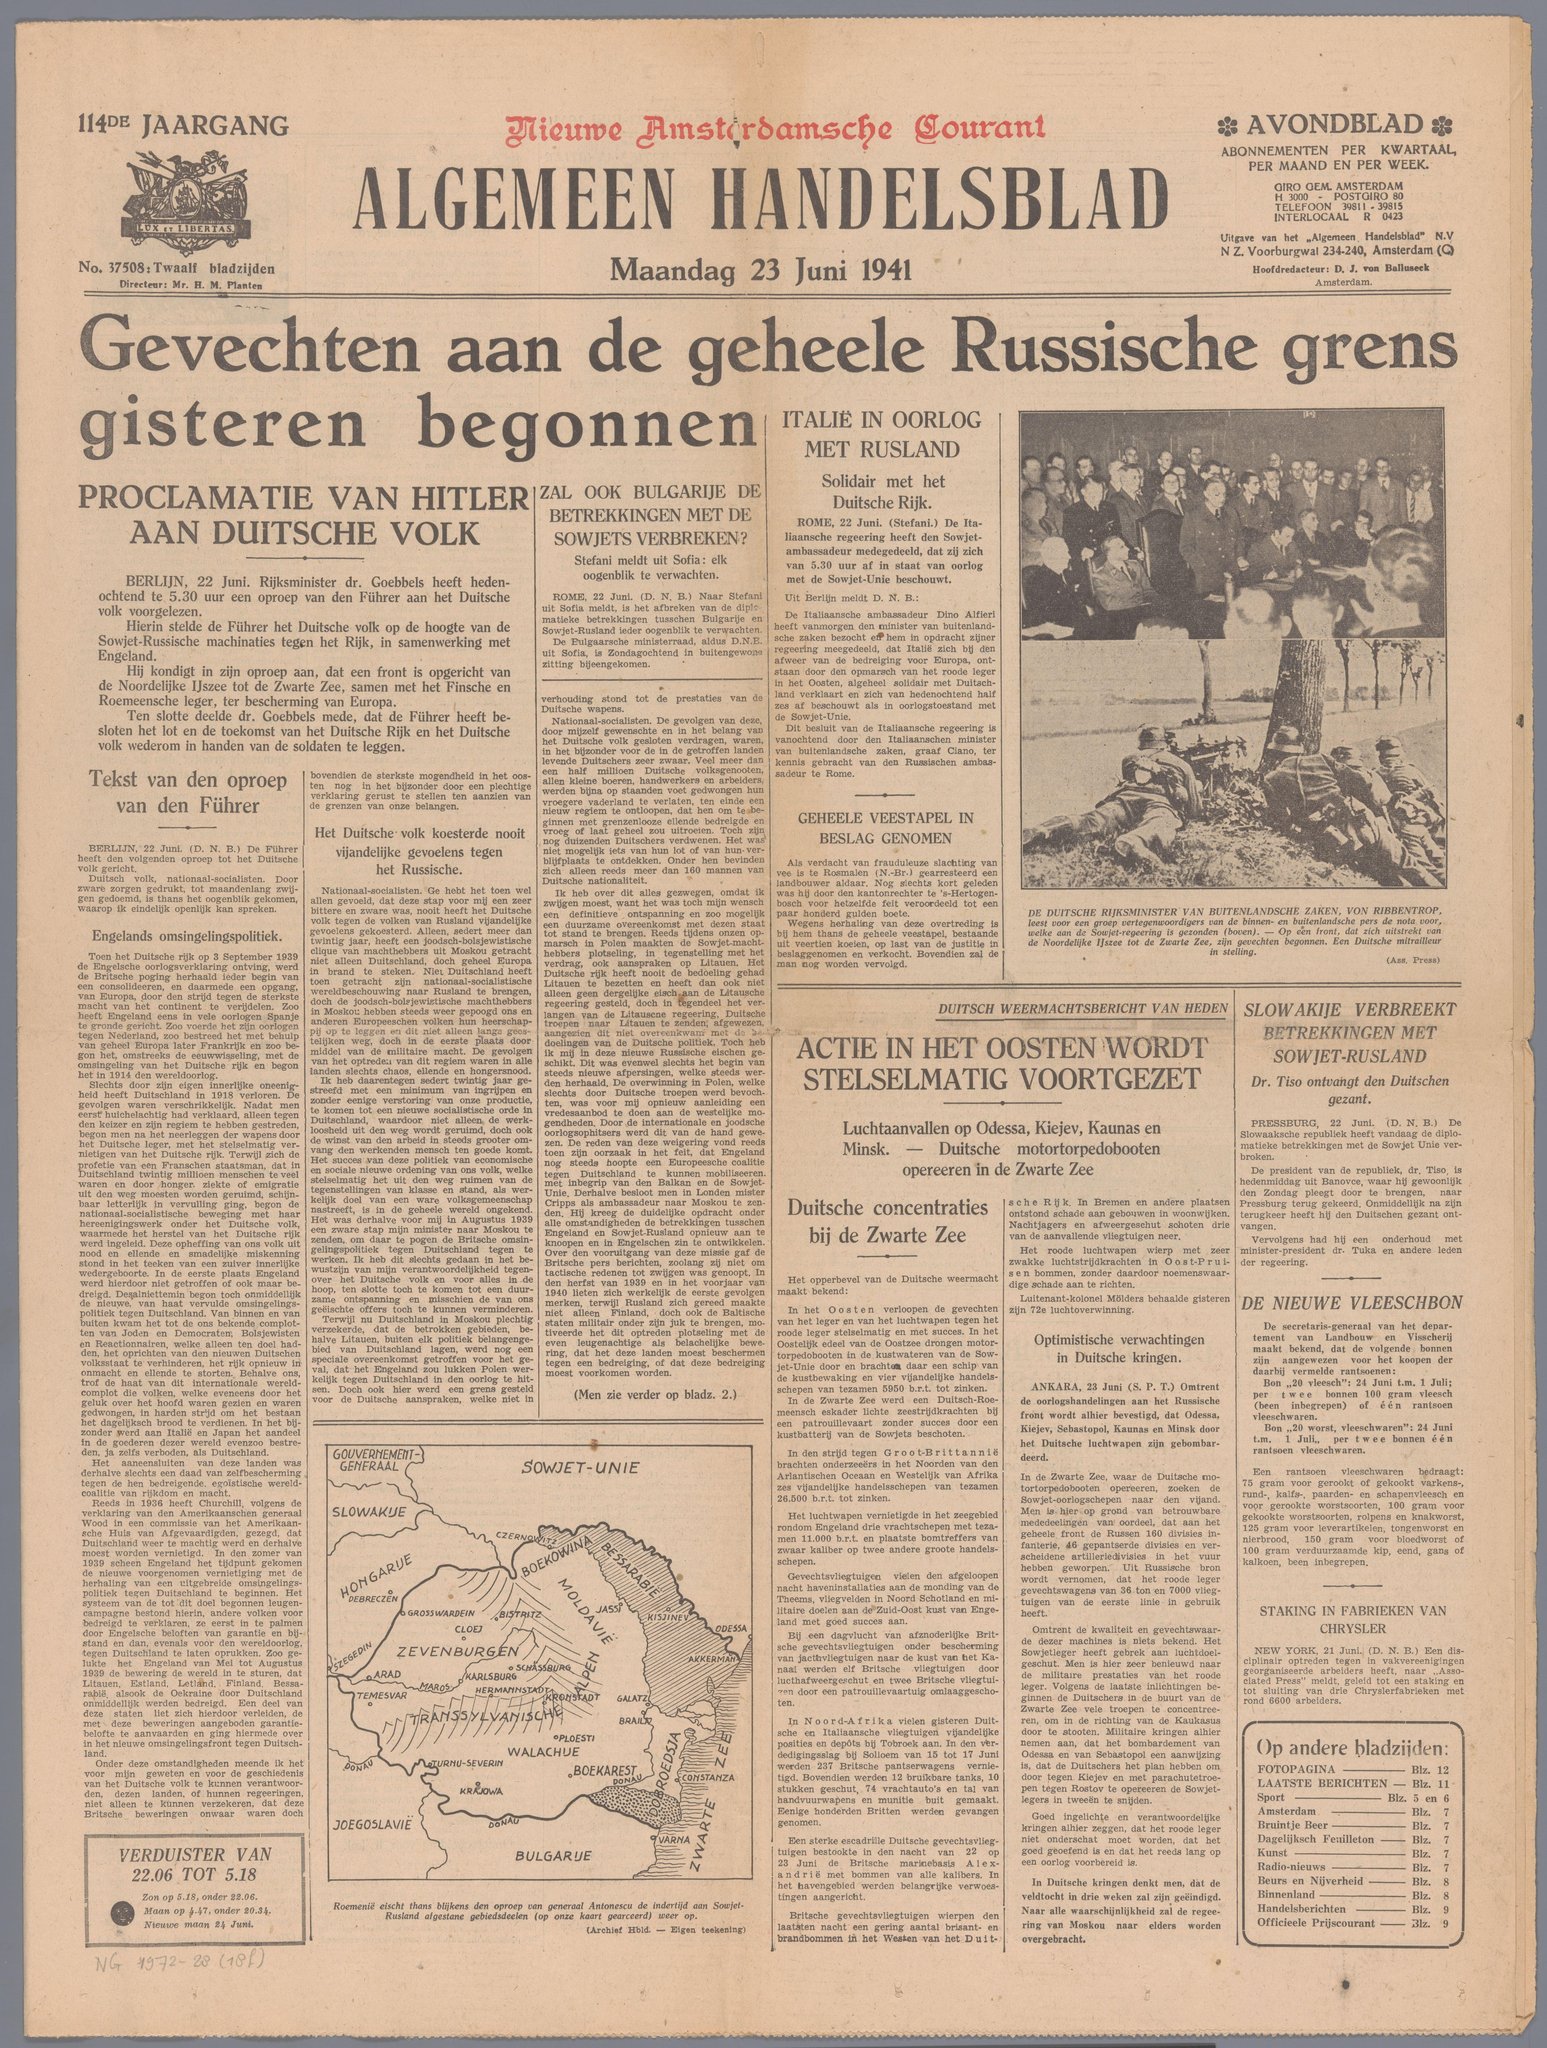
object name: newspaper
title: Algemeen Handelsblad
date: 1941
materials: paper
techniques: printing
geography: amsterdam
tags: siberië, tweede wereldoorlog, duitse inval in de sovjetunie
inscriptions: date